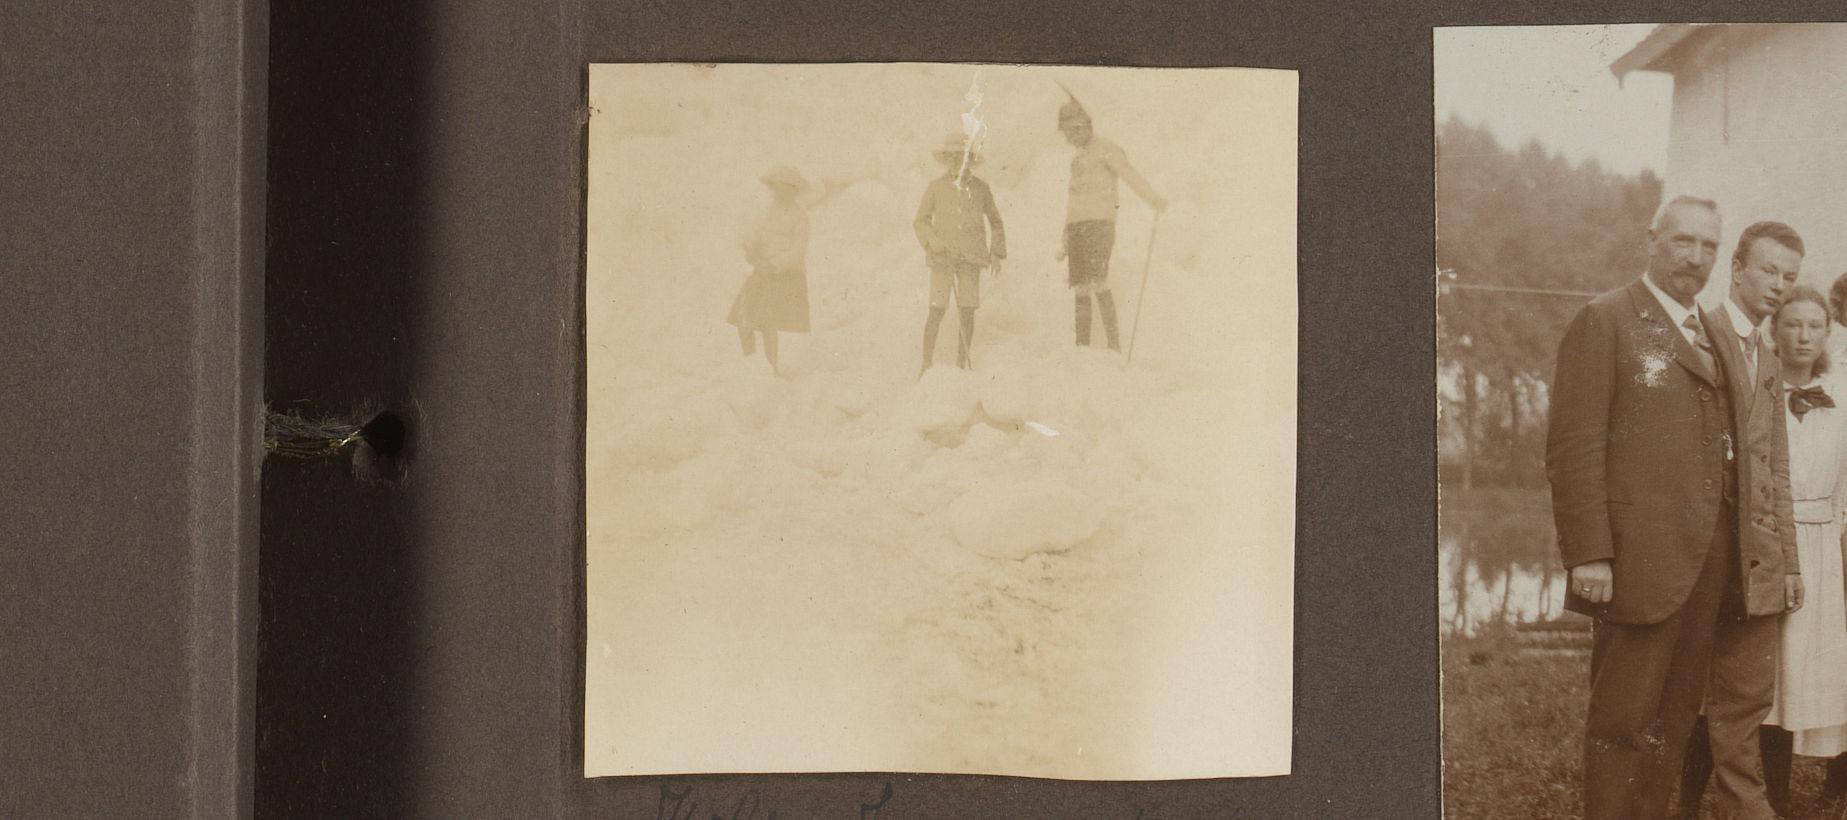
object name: photograph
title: Drie kinderen genaamd Hilda, Jan en Karl staand op een rots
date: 1905-1925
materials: paper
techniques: gelatin silver print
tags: rocks, historical persons not known by name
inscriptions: inscription: ‘Hilda, Jan en Karl’